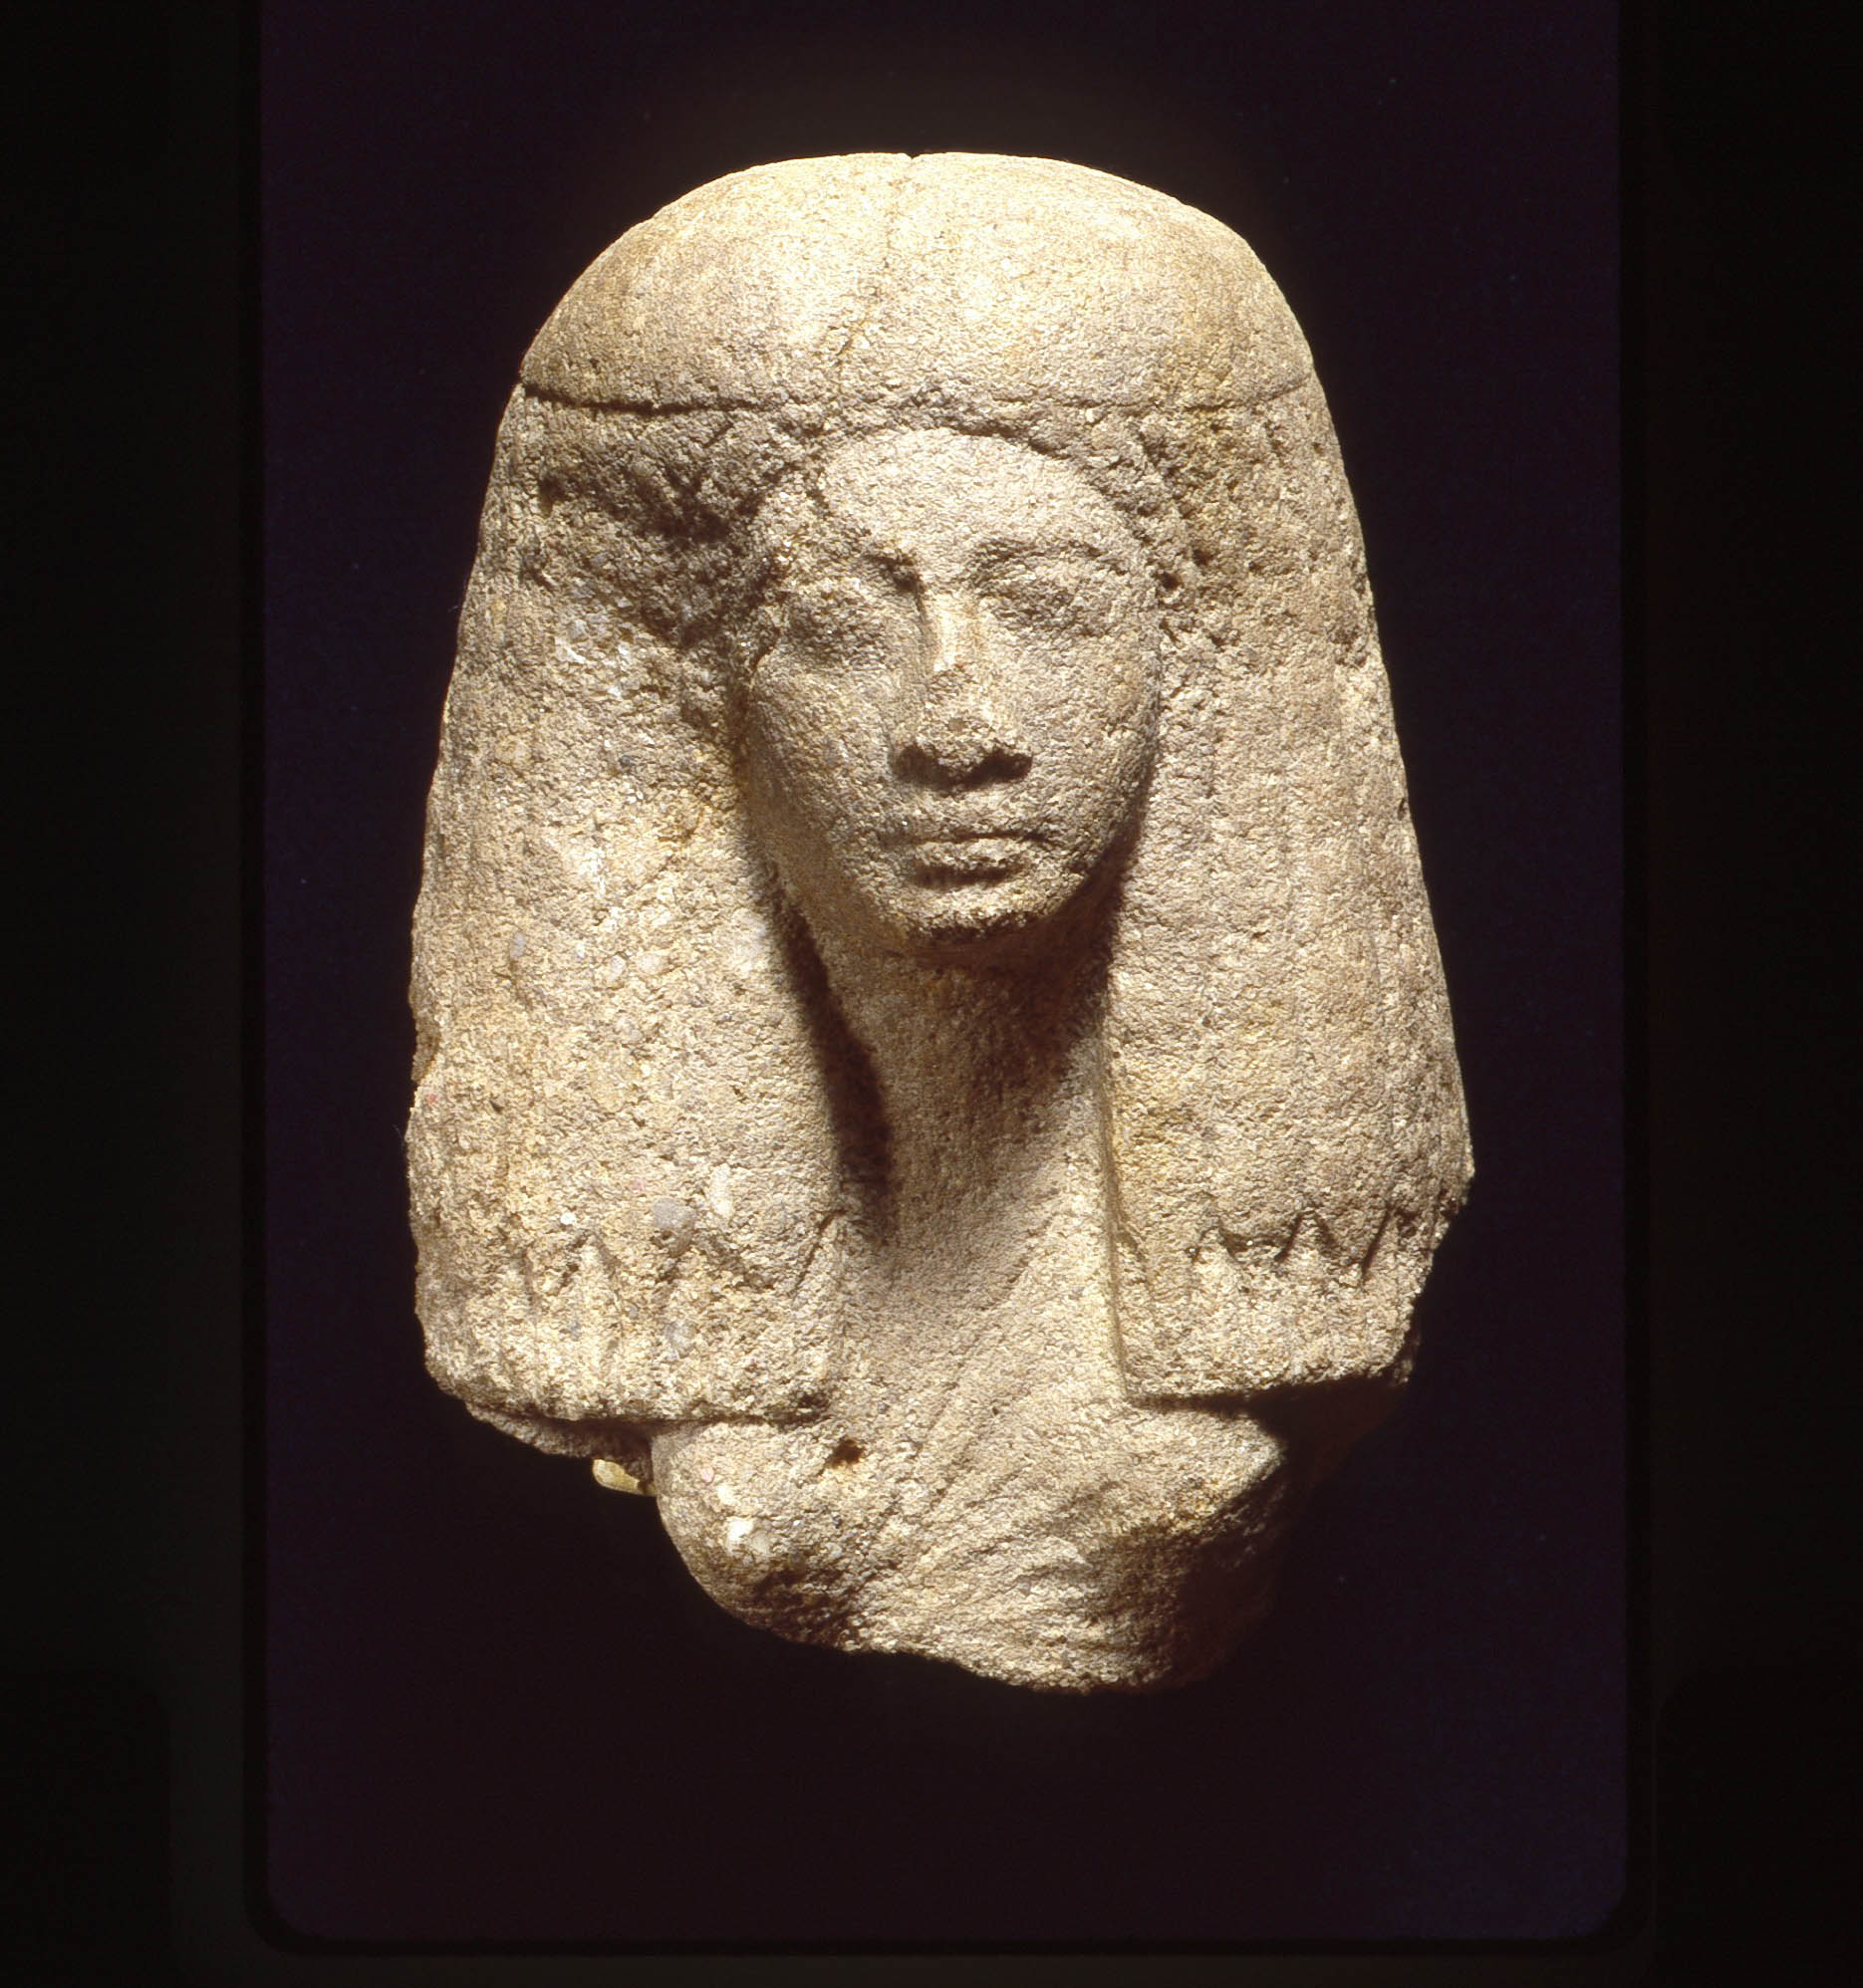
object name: statuette of a woman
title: Fragmentary Statuette of a Woman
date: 1295-1213 BCE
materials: quartzite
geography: egypt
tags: portraits,women